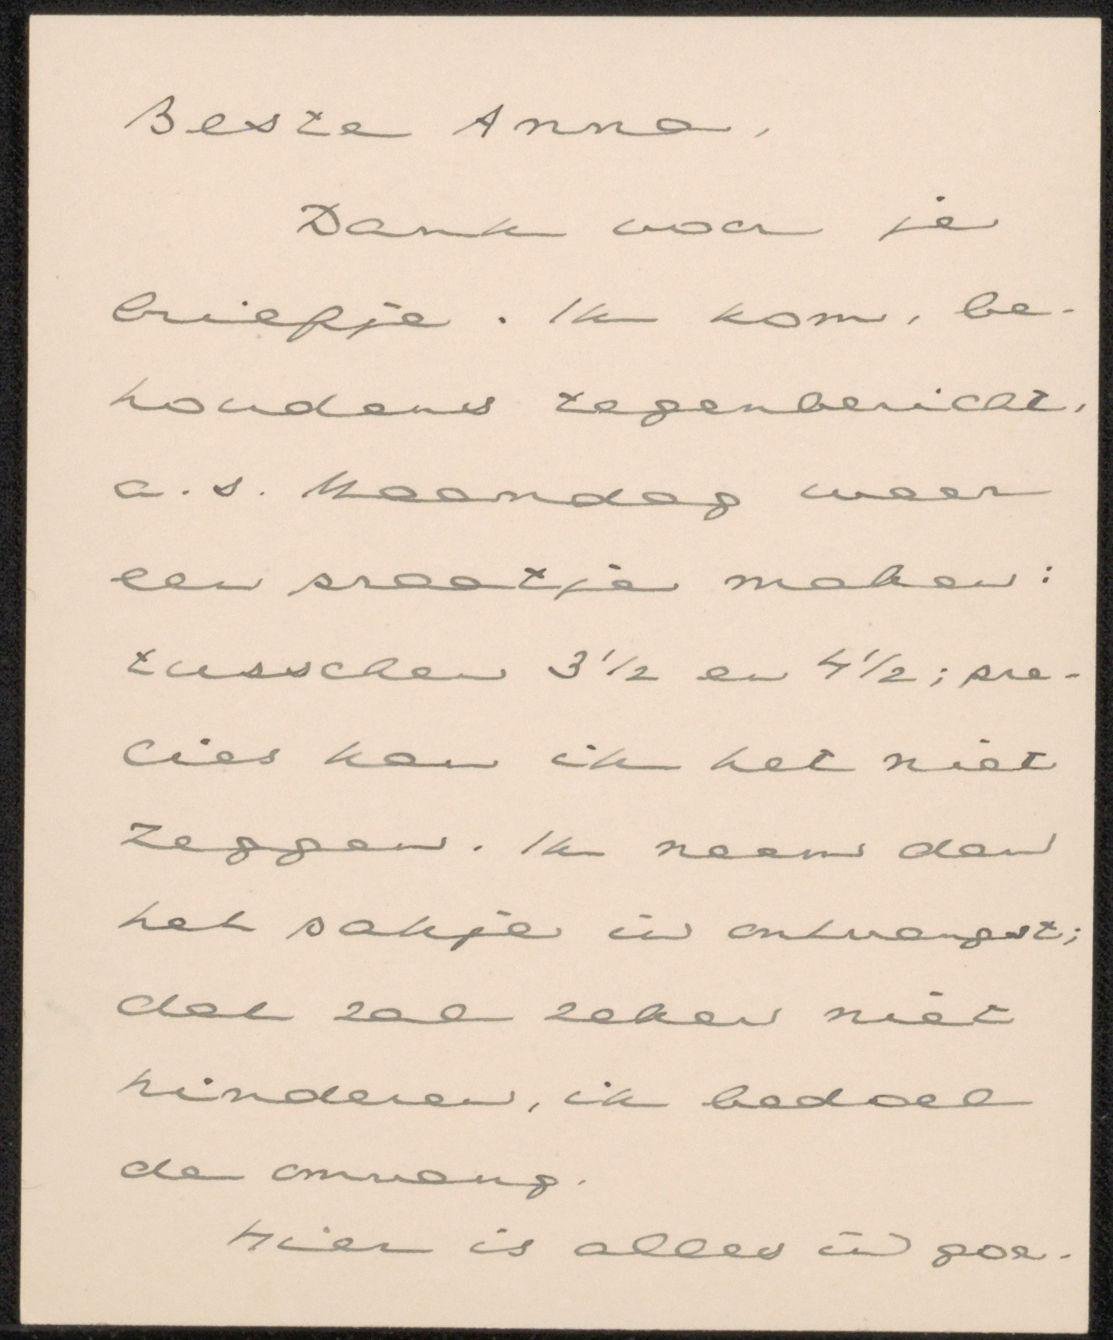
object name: letter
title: Brief aan Anna Dorothea Dirks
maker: johan huizinga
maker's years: 1872-1945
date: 1926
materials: ink, paper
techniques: pen, writing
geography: leiden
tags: artist, anna dorothea dirks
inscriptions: collector's mark: ‘RPK’